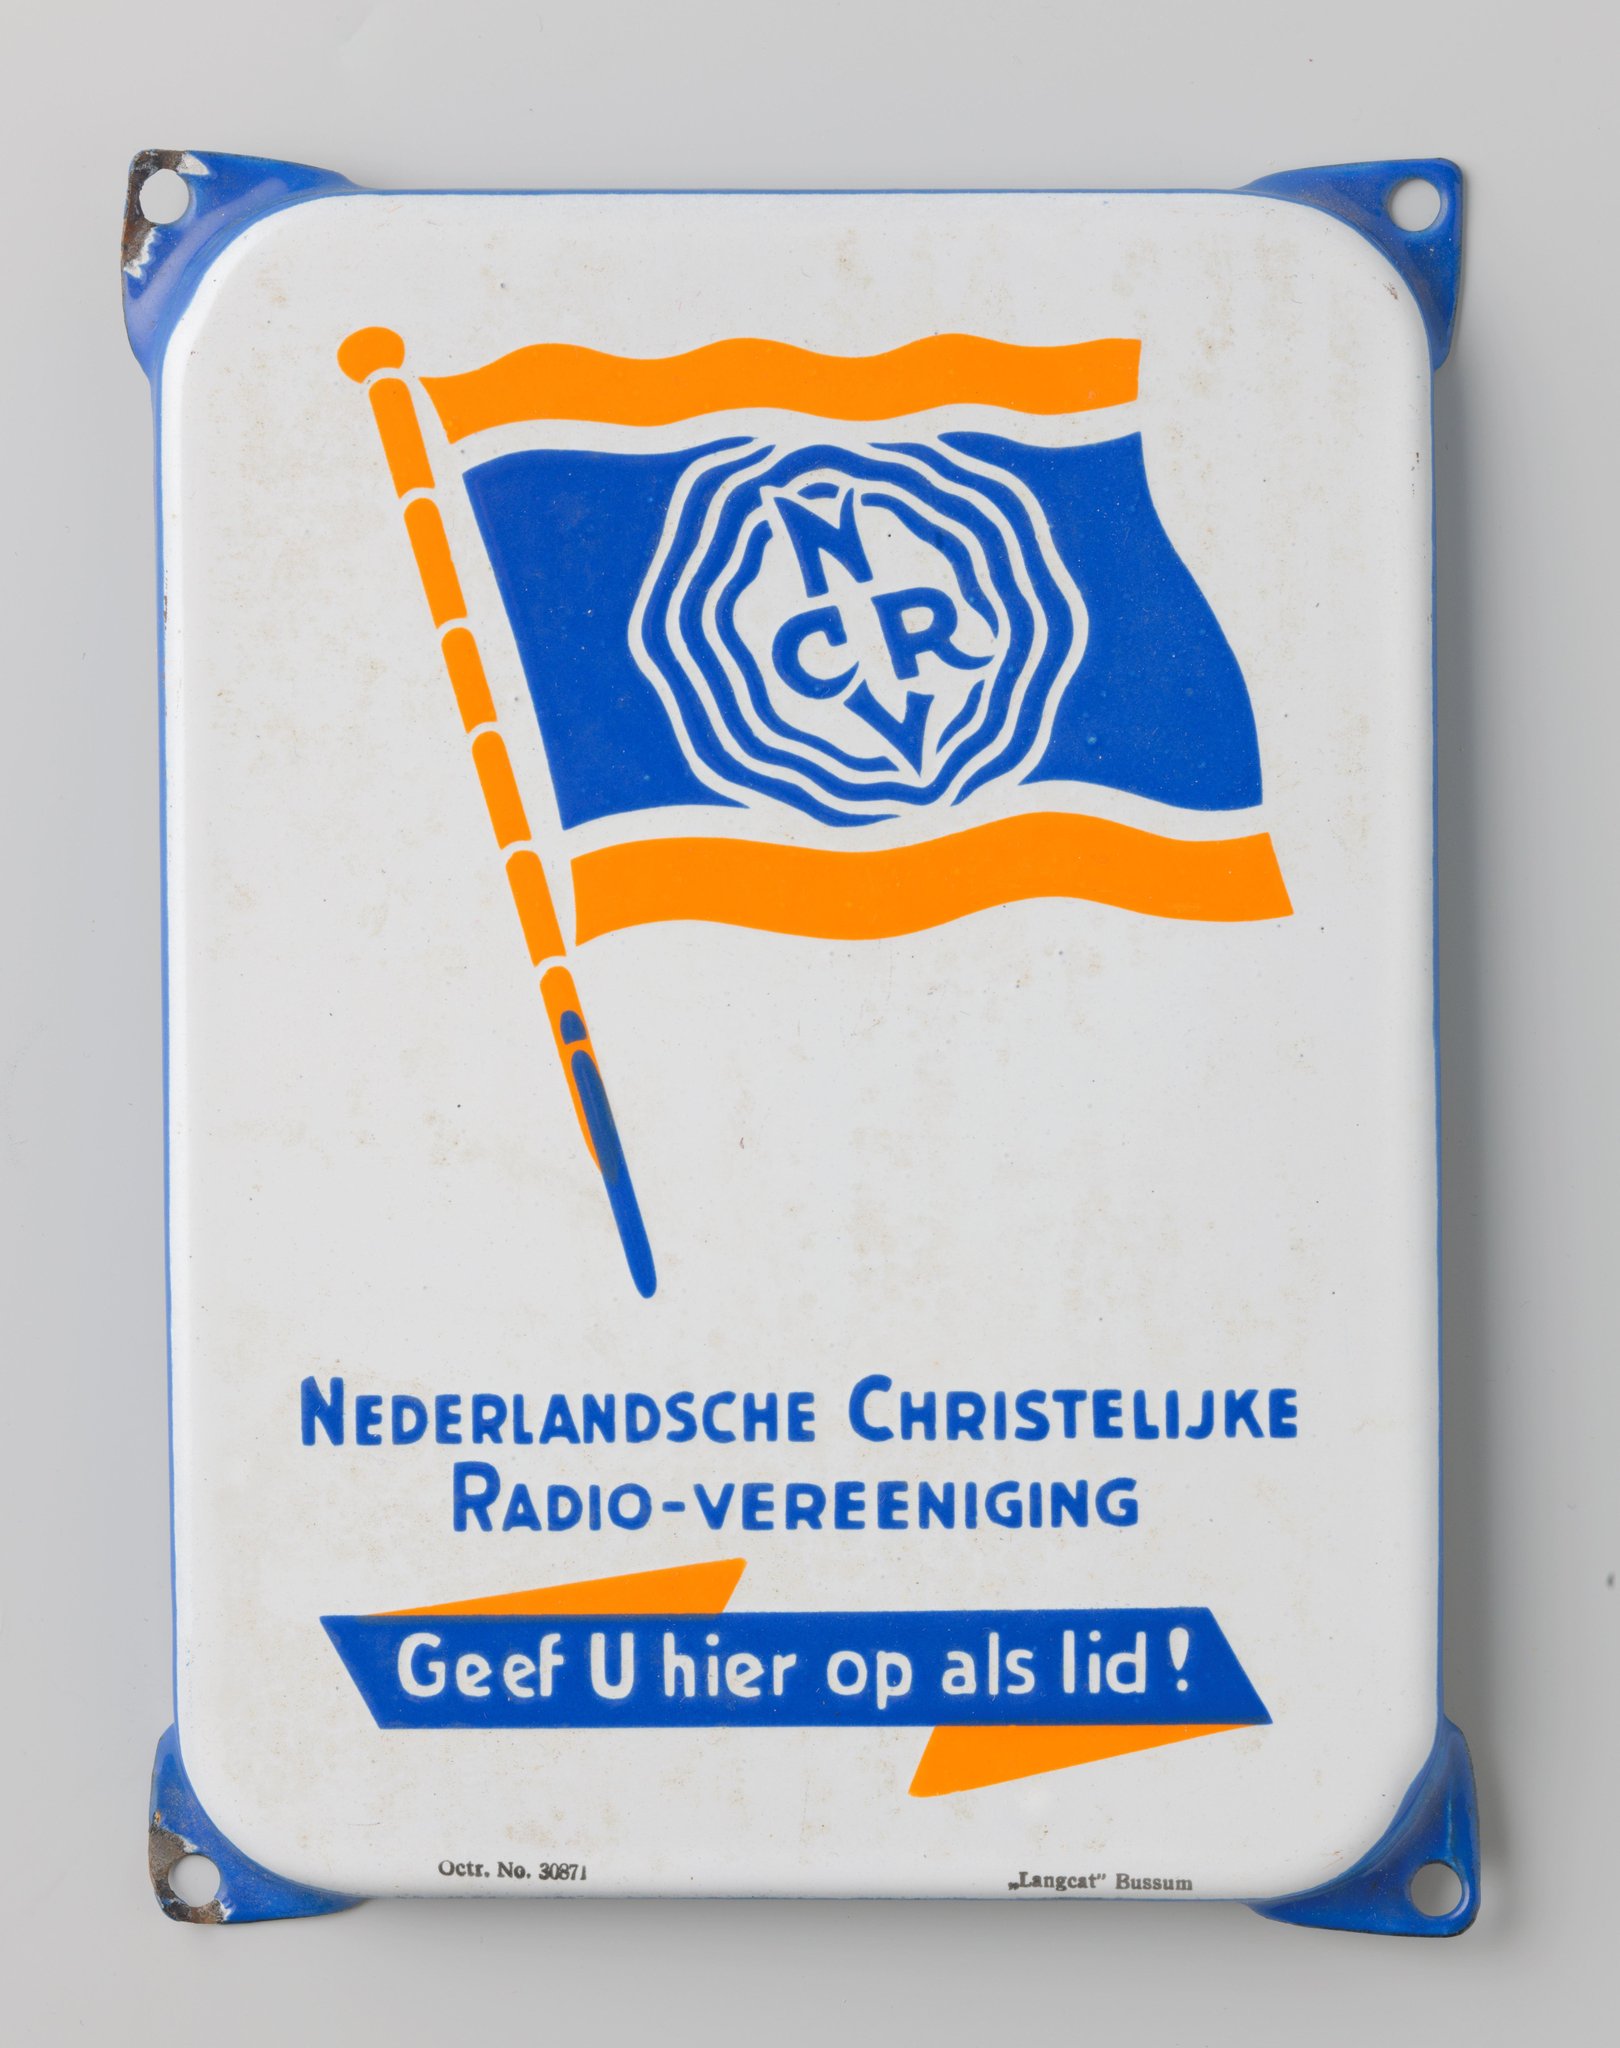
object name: billboard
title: Reclamebord van de Nederlandsche Christelijke Radio-vereeniging (NCRV)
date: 1924-1994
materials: metal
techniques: silvering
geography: bussum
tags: netherlands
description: Rechthoekig bord, met rond hoeken rond de beeldzijde. Op een witte achtergrond staat een vlag in oranje en blauw. Het embleem is een zeshoek met afgeronde hoeken en de letters N / CR / V. Hieronder een opschrift in blauw en een opschrift in wit op een blauwe band met oranje hoeken. Het bord heeft een blauwe opstaande rand en hoeken met (schroef)gaten. De keerzijde is zwart.